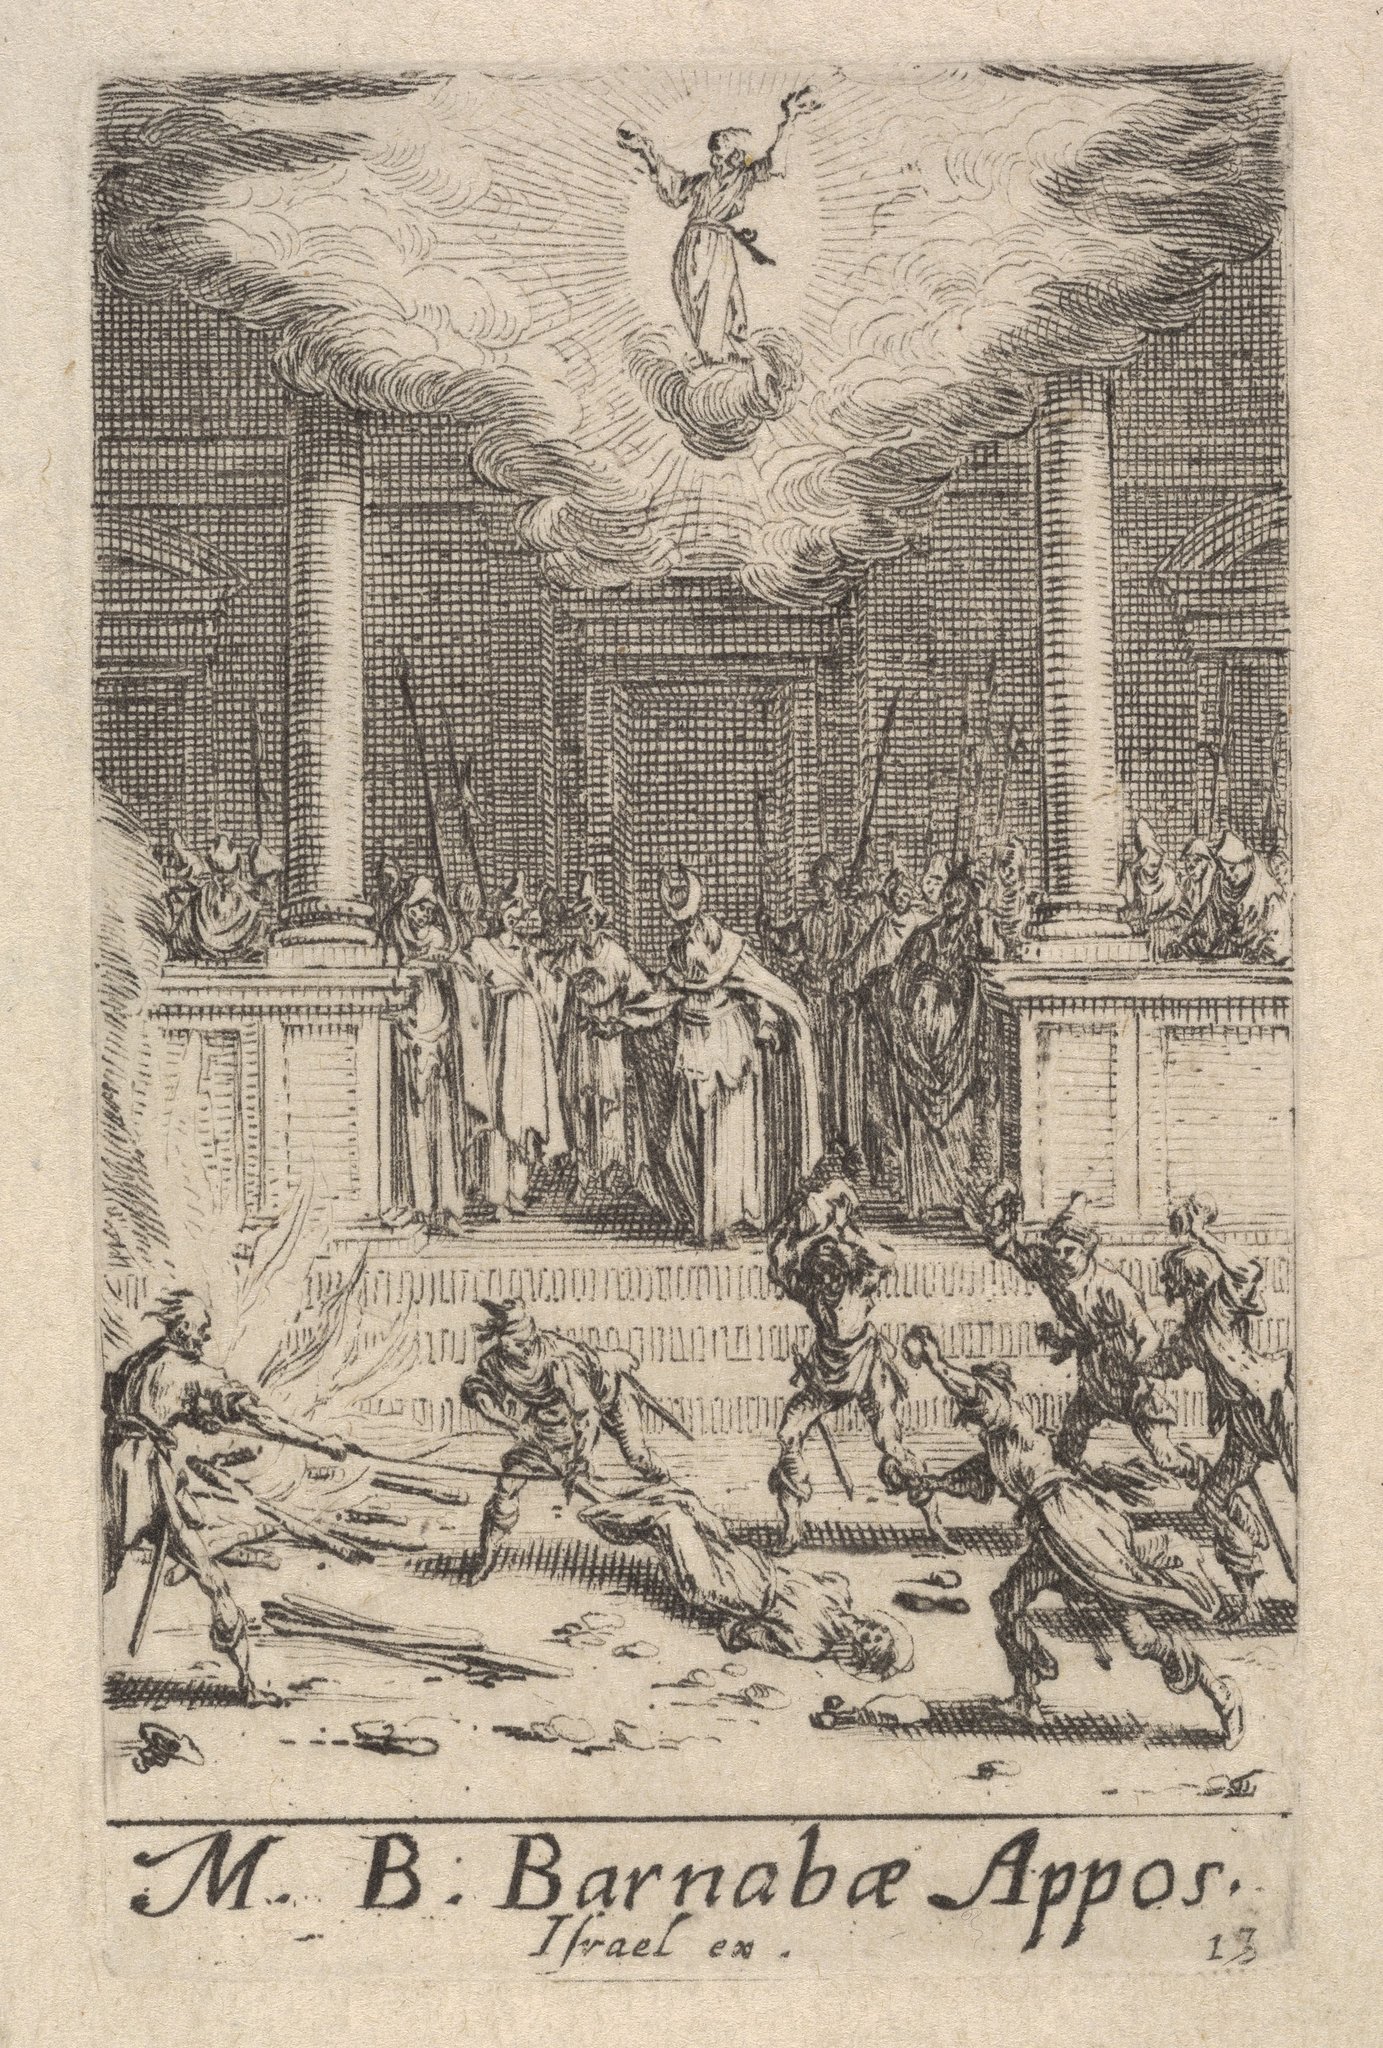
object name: print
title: Martyrdom of Saint Barnabas, from "The Little Apostles" (Les Petits Apôtres)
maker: jacques callot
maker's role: artist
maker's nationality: french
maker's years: 1592-1635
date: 1632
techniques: etching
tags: suffering,men,saints,death